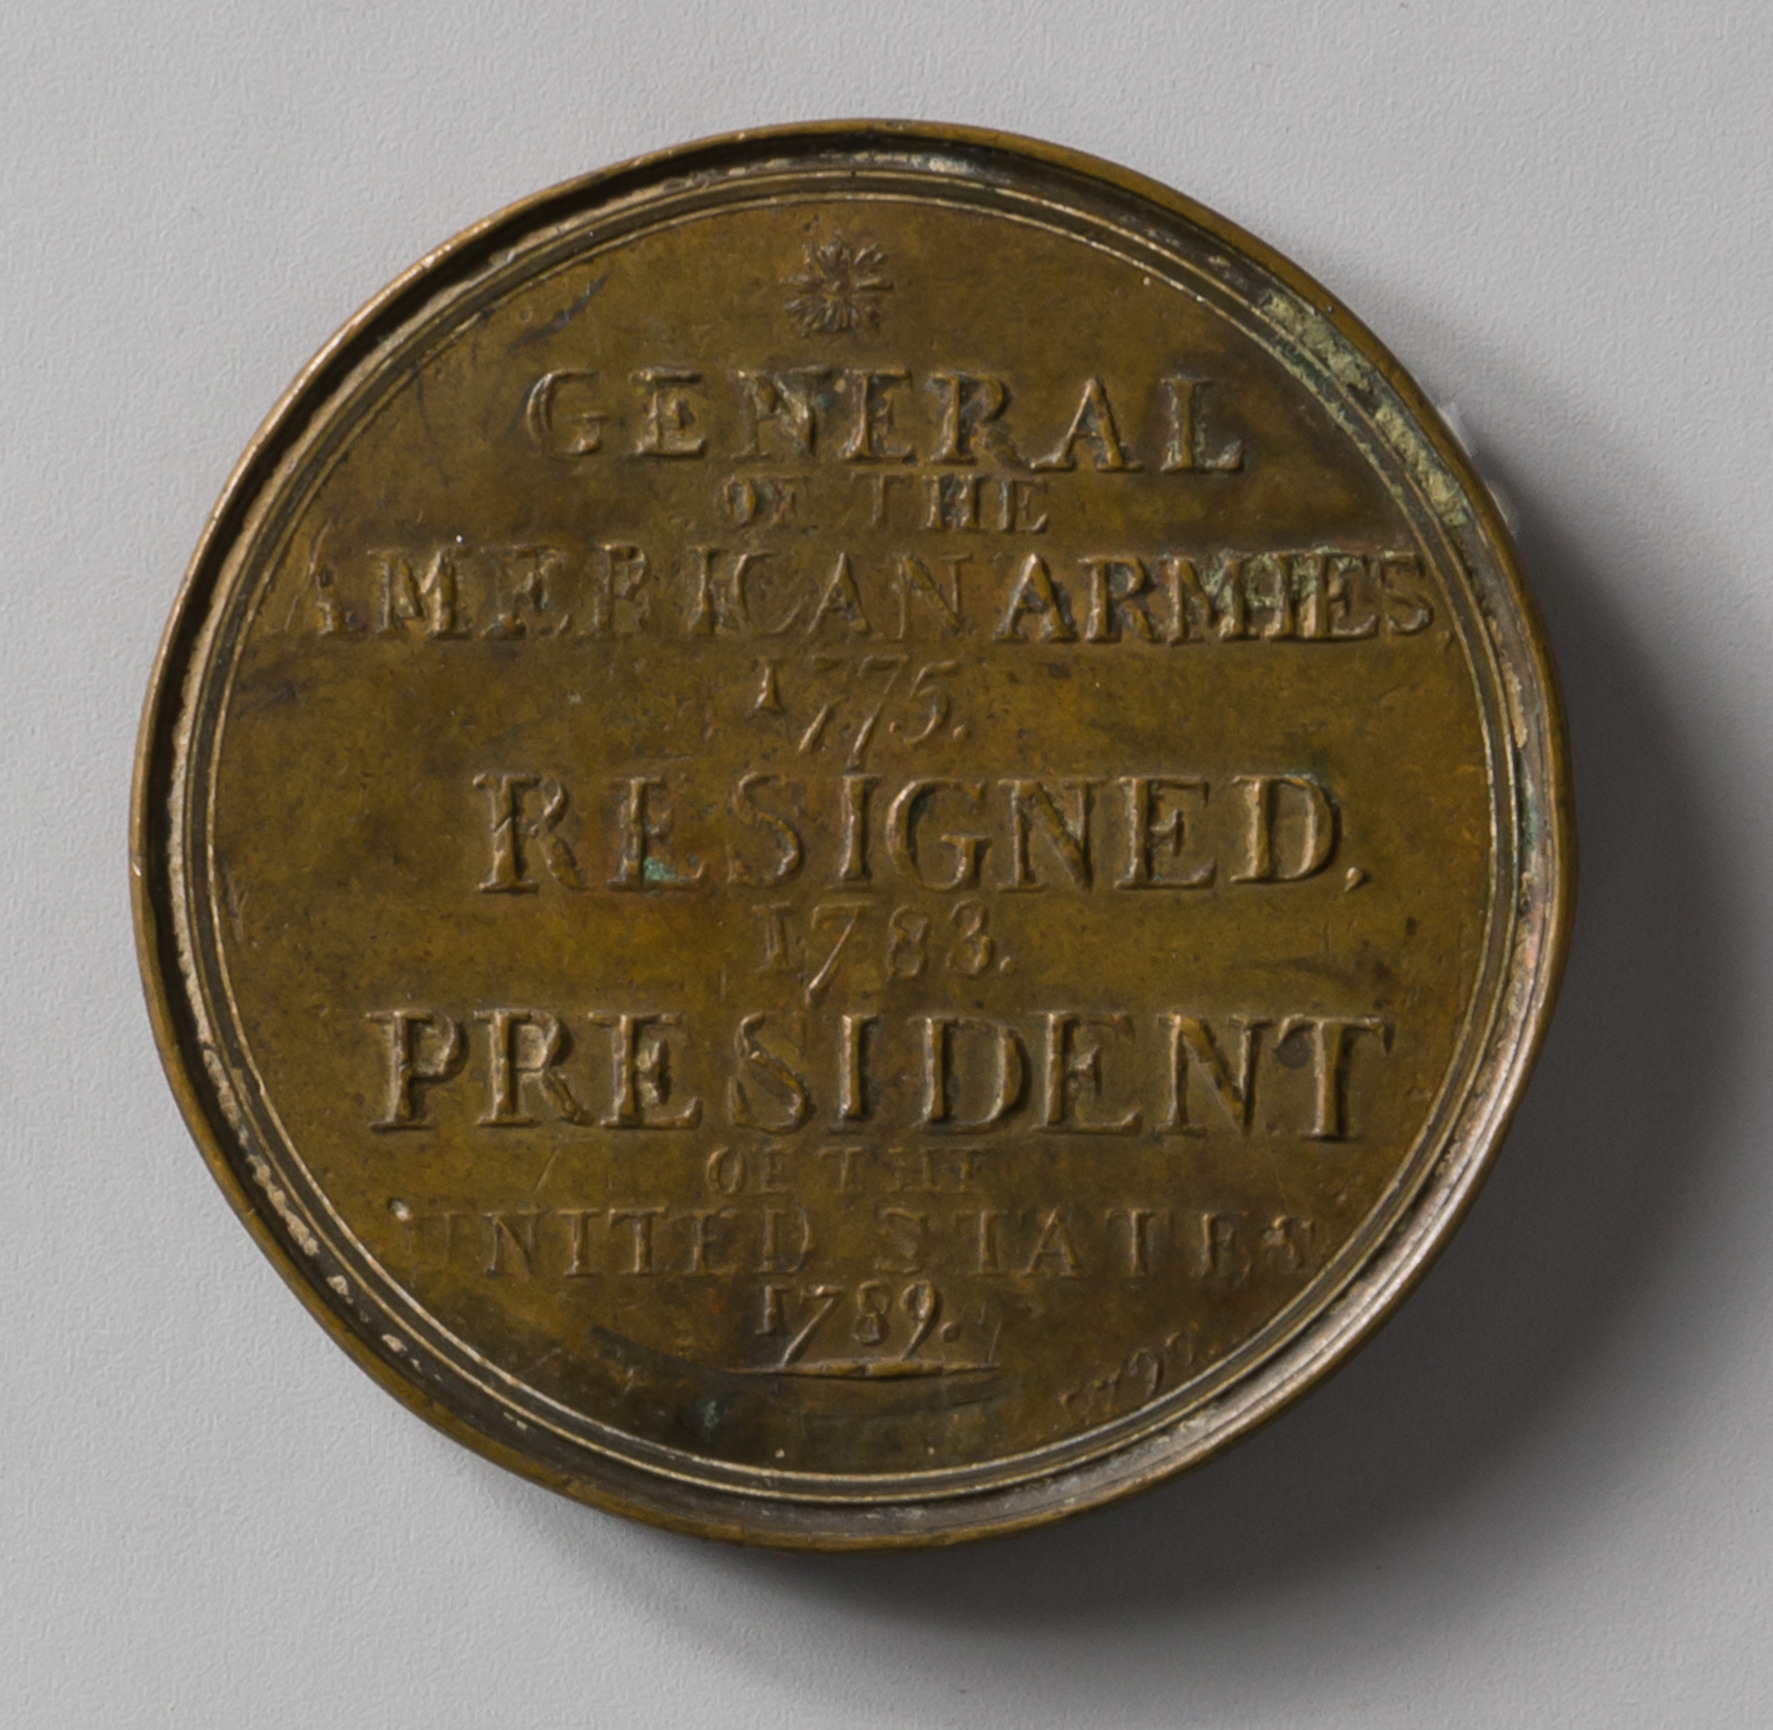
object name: medal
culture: american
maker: james manley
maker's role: maker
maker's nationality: american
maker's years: 1790-1800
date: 1790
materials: gilt bronze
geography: united states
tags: george washington